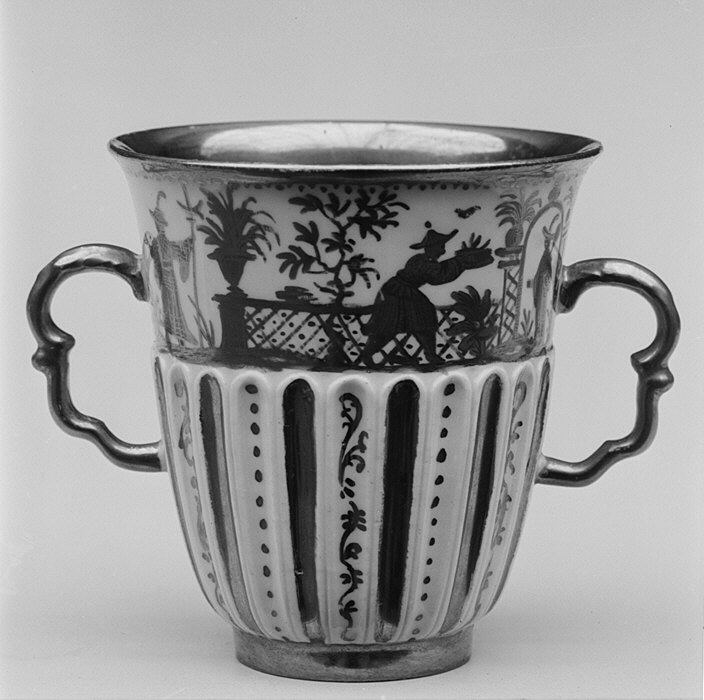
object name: cup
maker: meissen manufactory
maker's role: manufactory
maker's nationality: german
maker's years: 1710-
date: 1701-1800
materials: hard paste porcelain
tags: human figures,plants